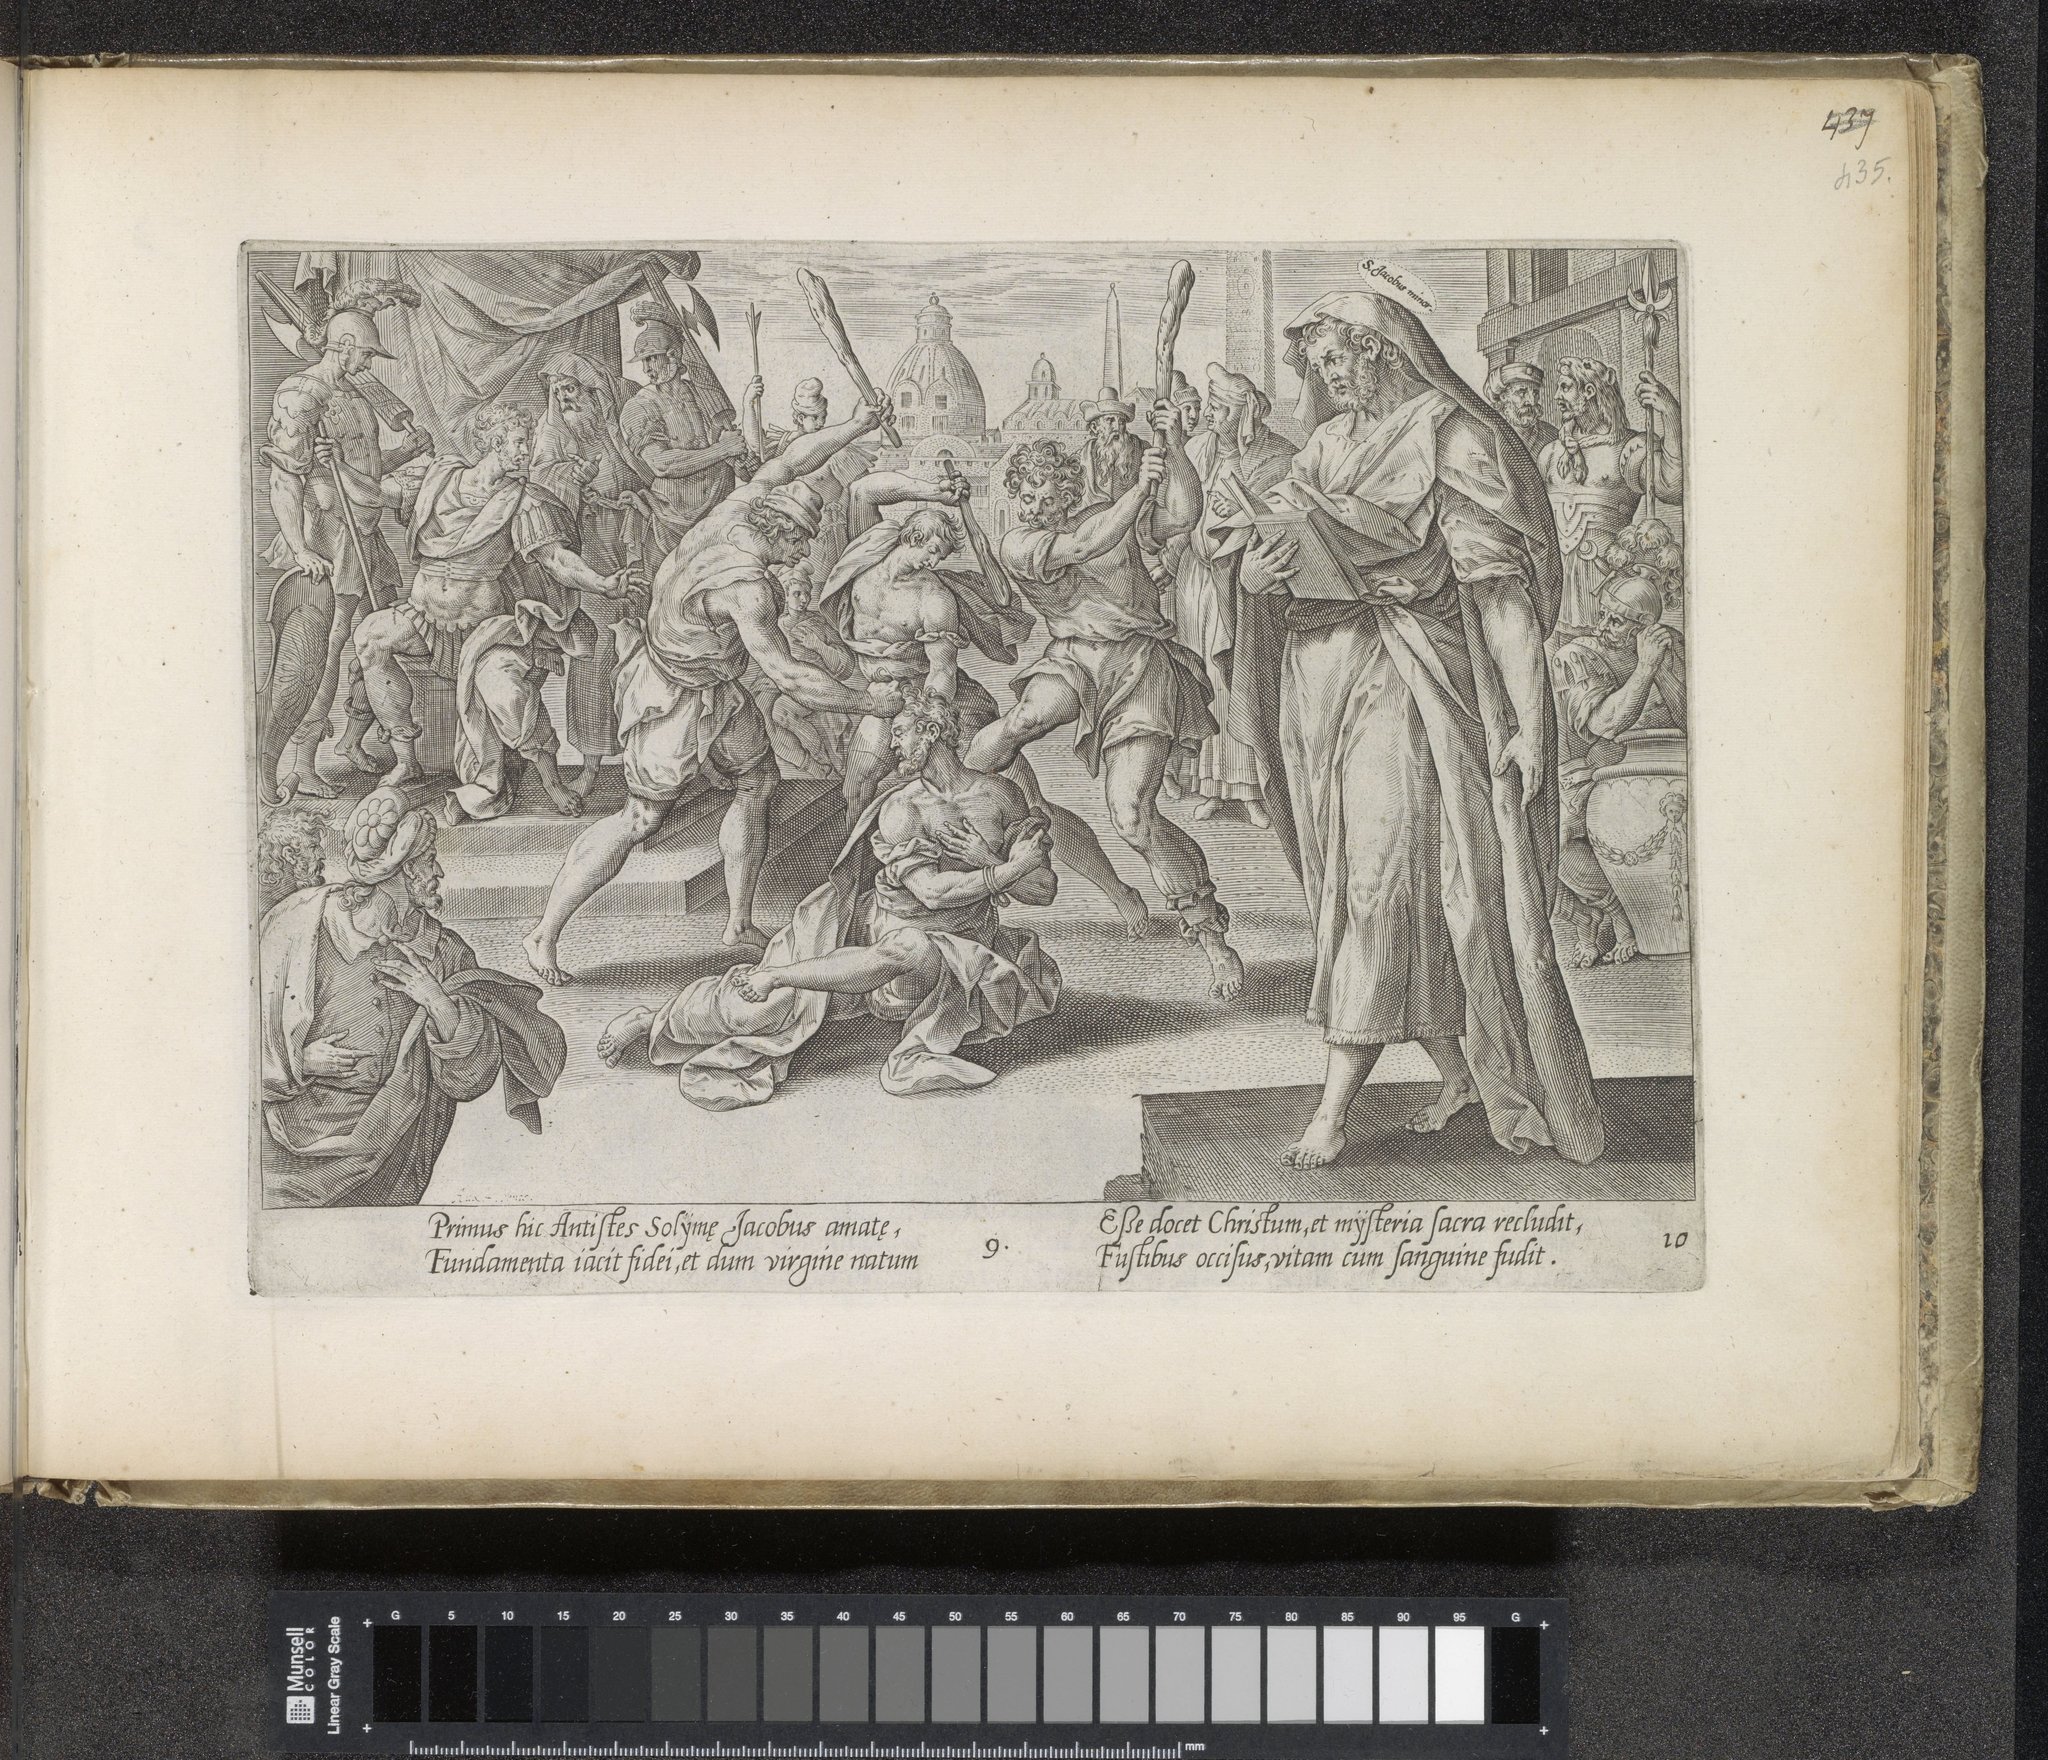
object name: print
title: Martelaarschap van Jakobus de Mindere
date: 1576-1580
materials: paper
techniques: engraving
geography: amsterdam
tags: james is stoned, or beaten to death (with a fuller's club), the apostle james the less, first bishop of jerusalem; possible attributes: book, fuller's club, scroll - martyrdom, suffering, misfortune, death of male saint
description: Jakobus de Mindere wordt door mannen met knuppels doodgeslagen. Rechts naast het tafereel van zijn marteldood staat hij nogmaals afgebeeld, met een boek in de hand. Onder de voorstelling een verklarende tekst in het Latijn. Deze prent maakt deel uit van een album.